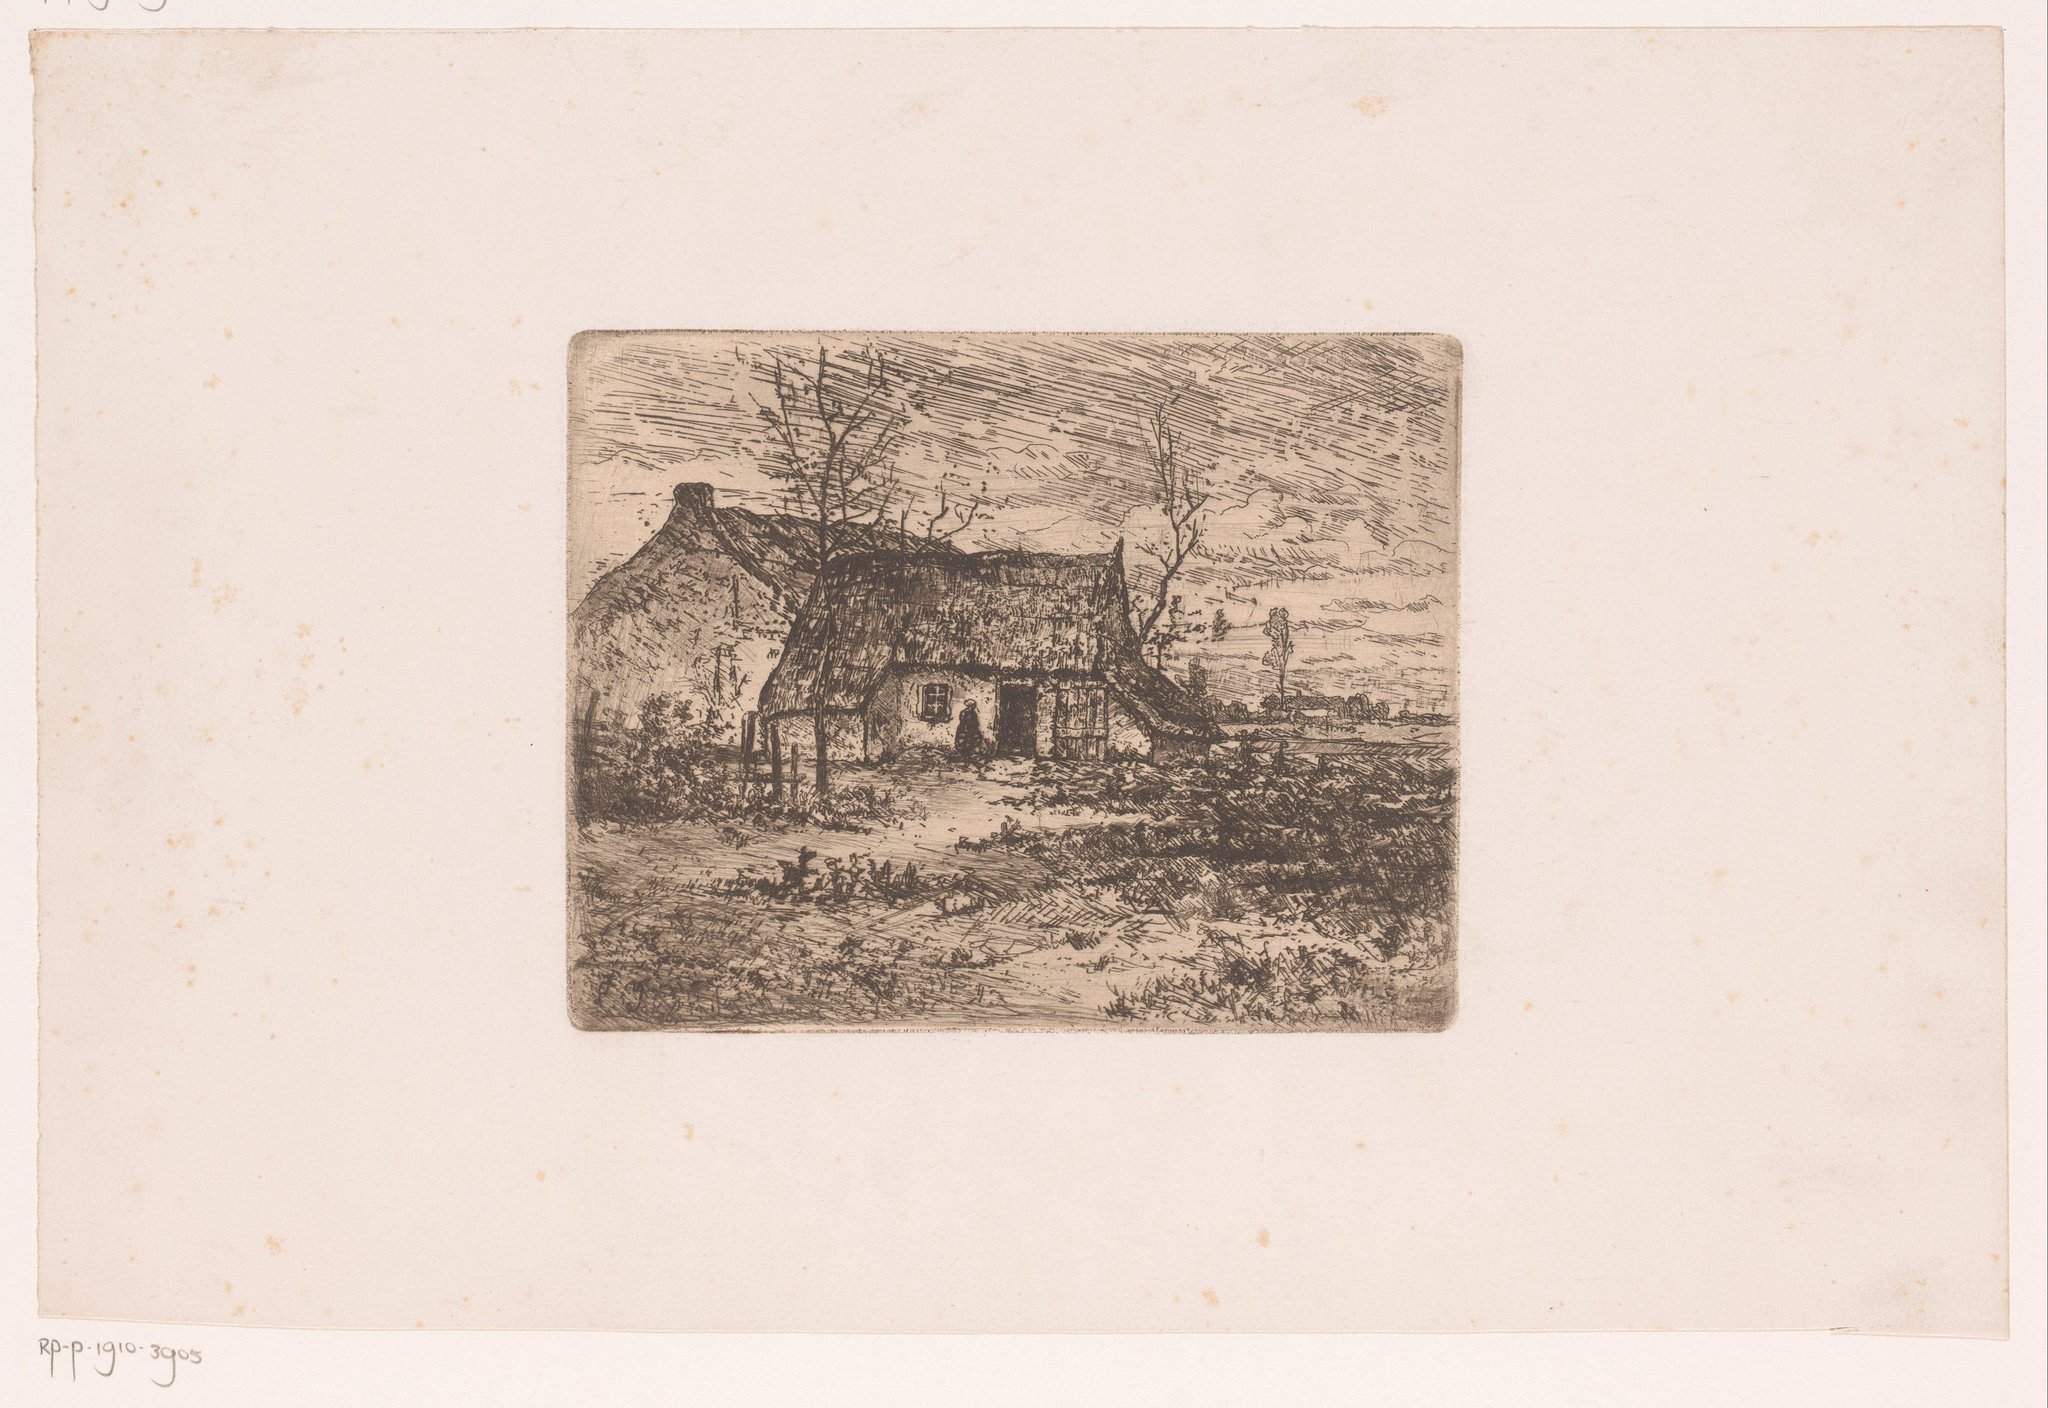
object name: print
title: Boerin voor een boerderij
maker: louis adolphe jacobs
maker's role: painter, print maker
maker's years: 1855-1929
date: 1865-1910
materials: paper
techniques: etching, intaglio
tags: farm or solitary house in landscape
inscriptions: collector's mark: Lugt 2228